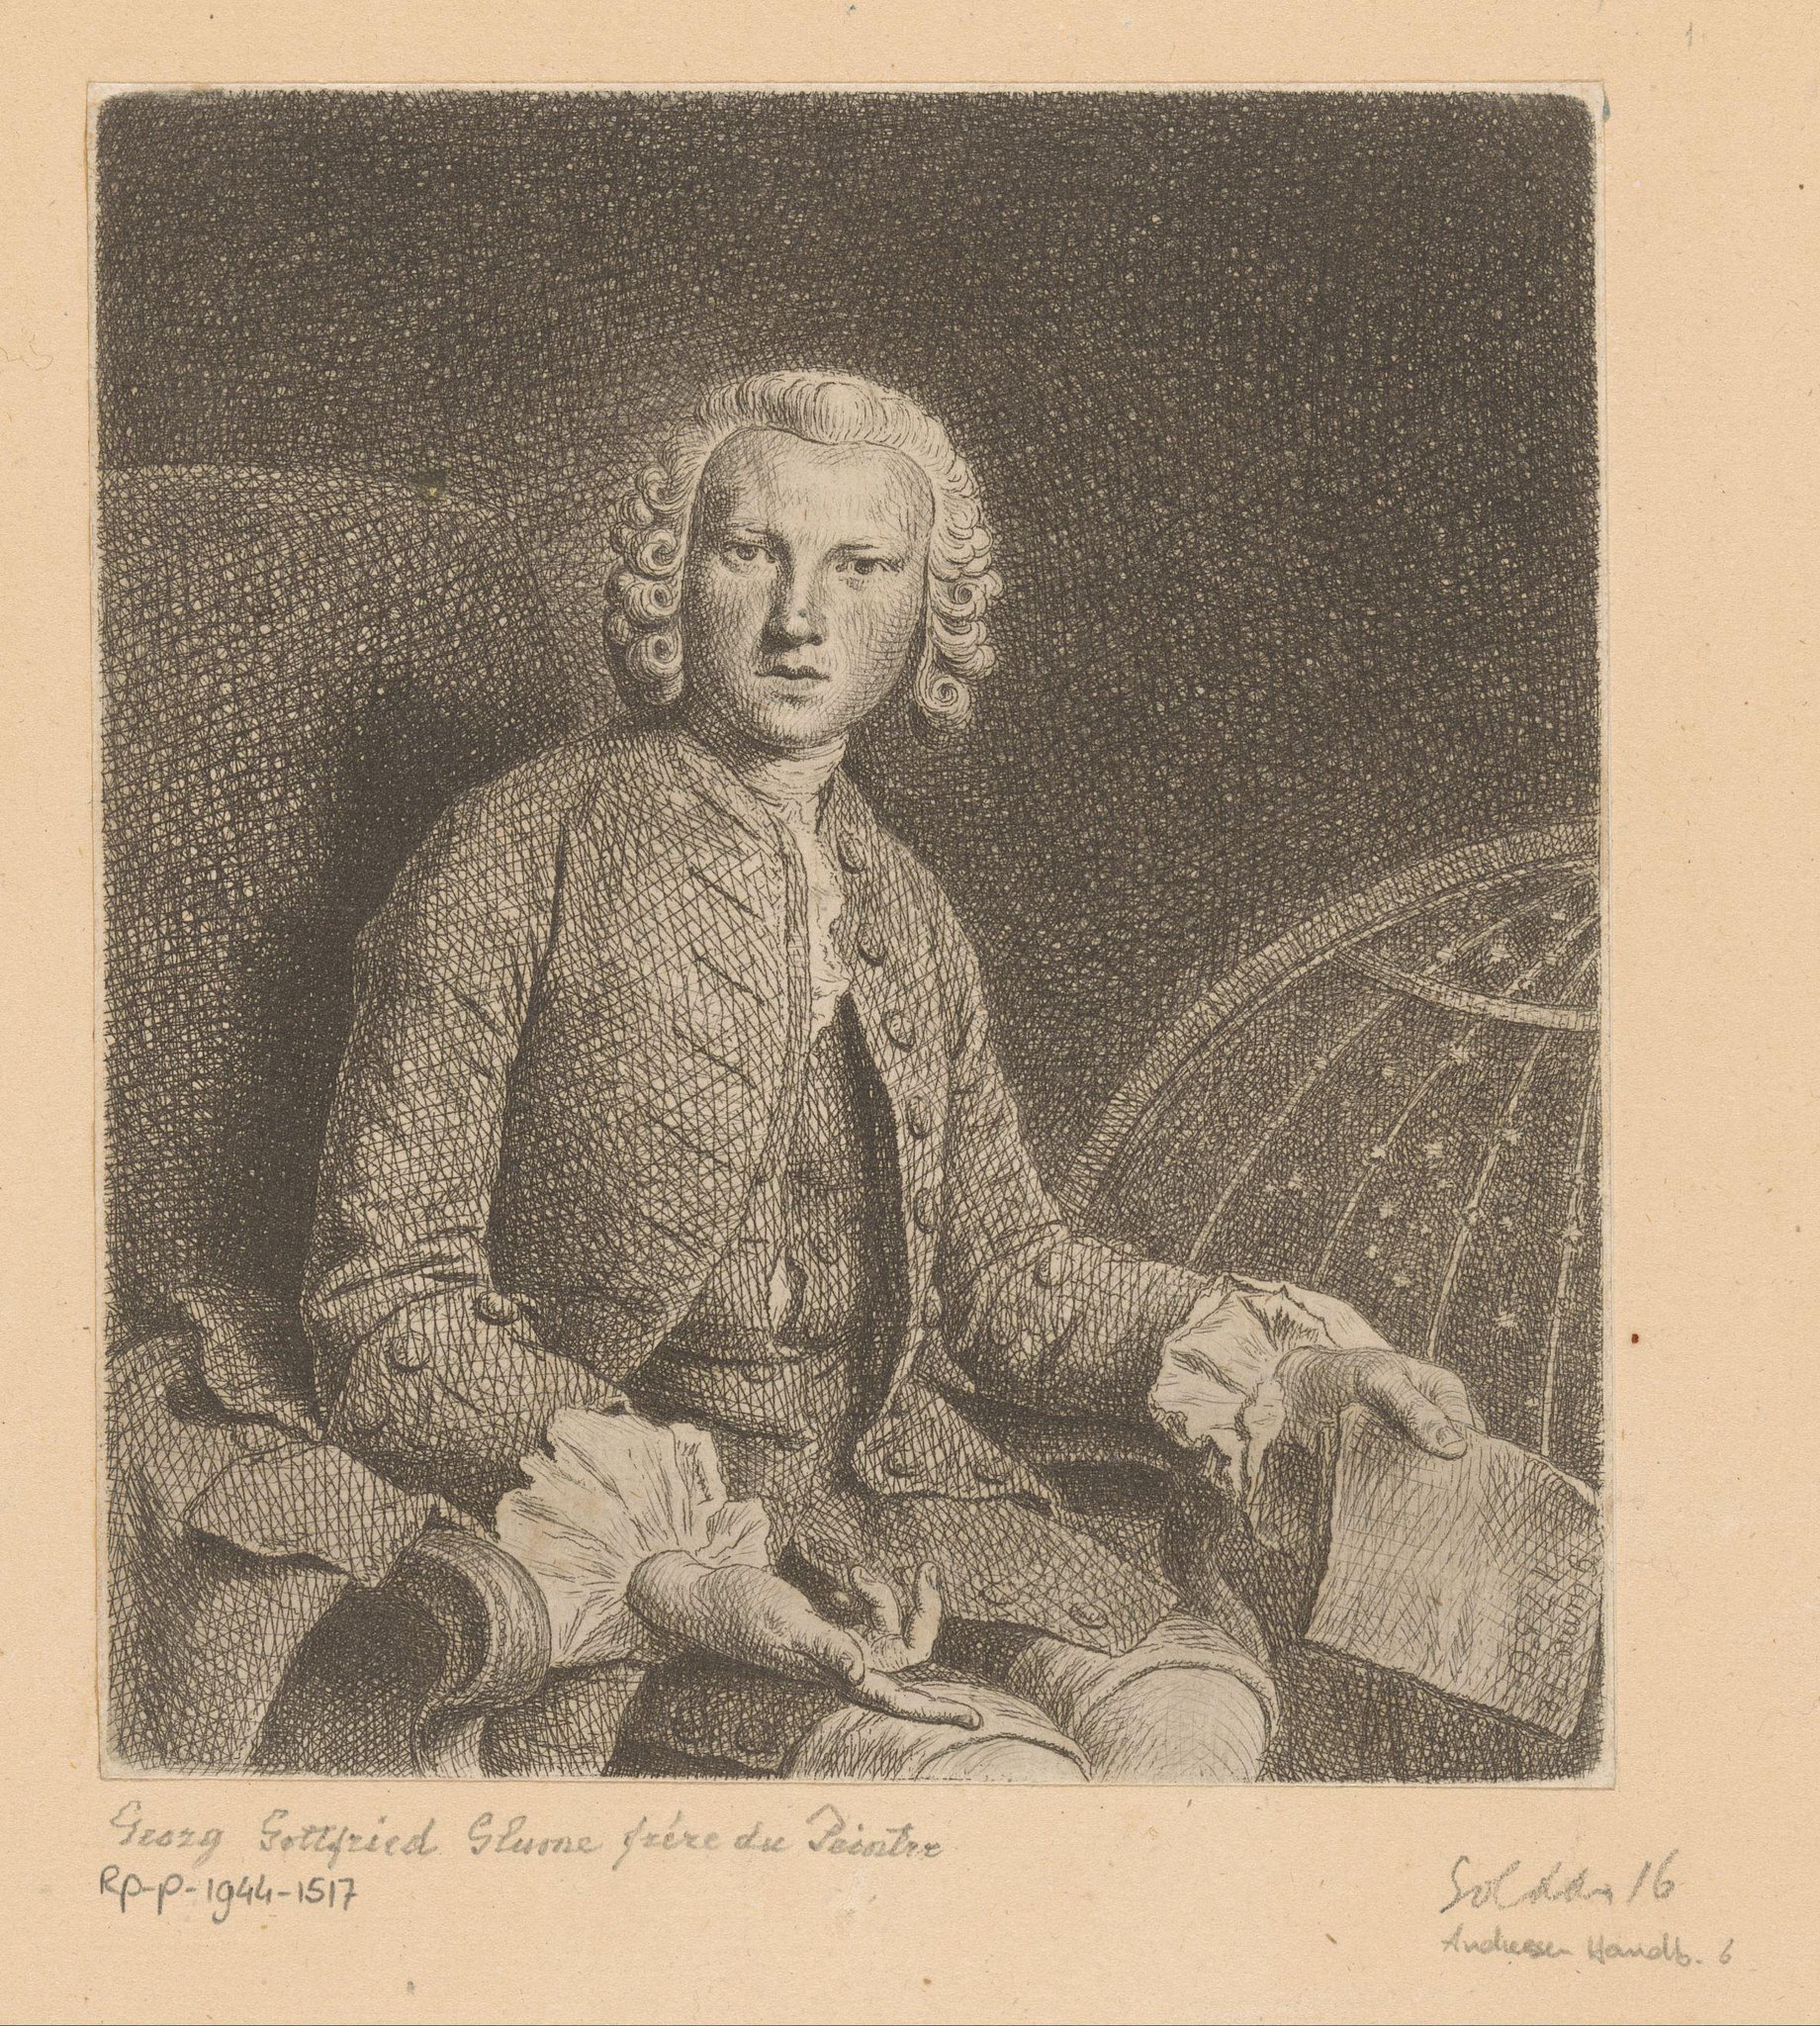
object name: print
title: Portret van Georg Gottfried Glume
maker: johann gottlieb glume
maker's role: print maker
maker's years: 1711-1778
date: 1750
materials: paper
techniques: etching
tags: berlin, historical persons, star-globe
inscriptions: date